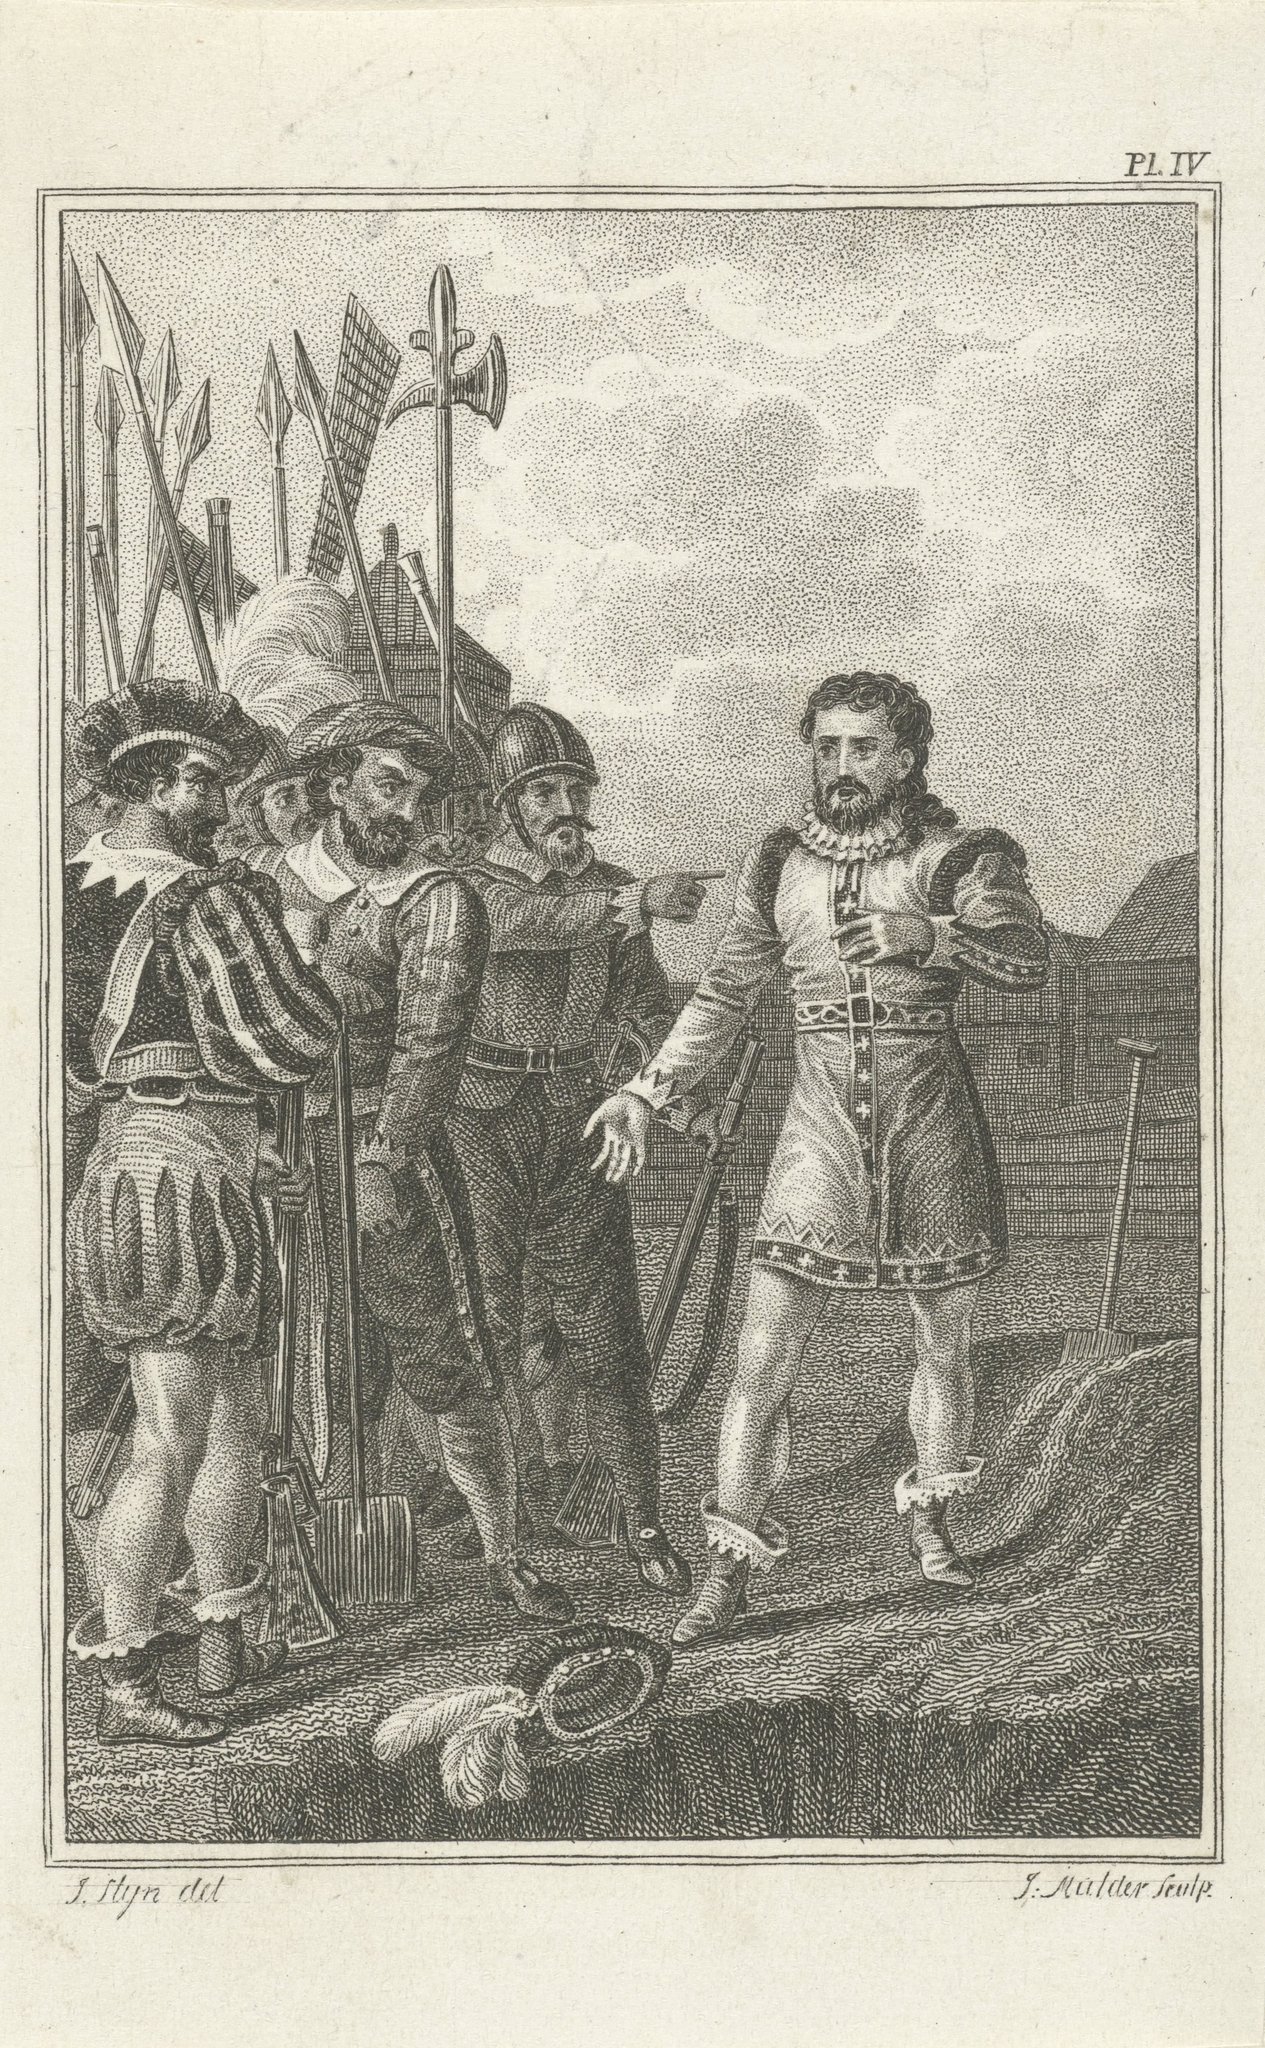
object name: print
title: Soldaten met schoppen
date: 1829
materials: paper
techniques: etching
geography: amsterdam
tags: digging (industrial process), agricultural implements: spade, the soldier; the soldier's life, threatening behaviour, challenging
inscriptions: collector's mark: Lugt 2228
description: Prent mogelijk gebruikt in: Muller, Johan Frederik Lodewĳk, César Auguste P. Weissman de Villez. Leven en karakterschets van Alexander den Macedoniër : benevens mengelingen van onderscheiden aard. Amsterdam: Frederik Kaal, 1829.